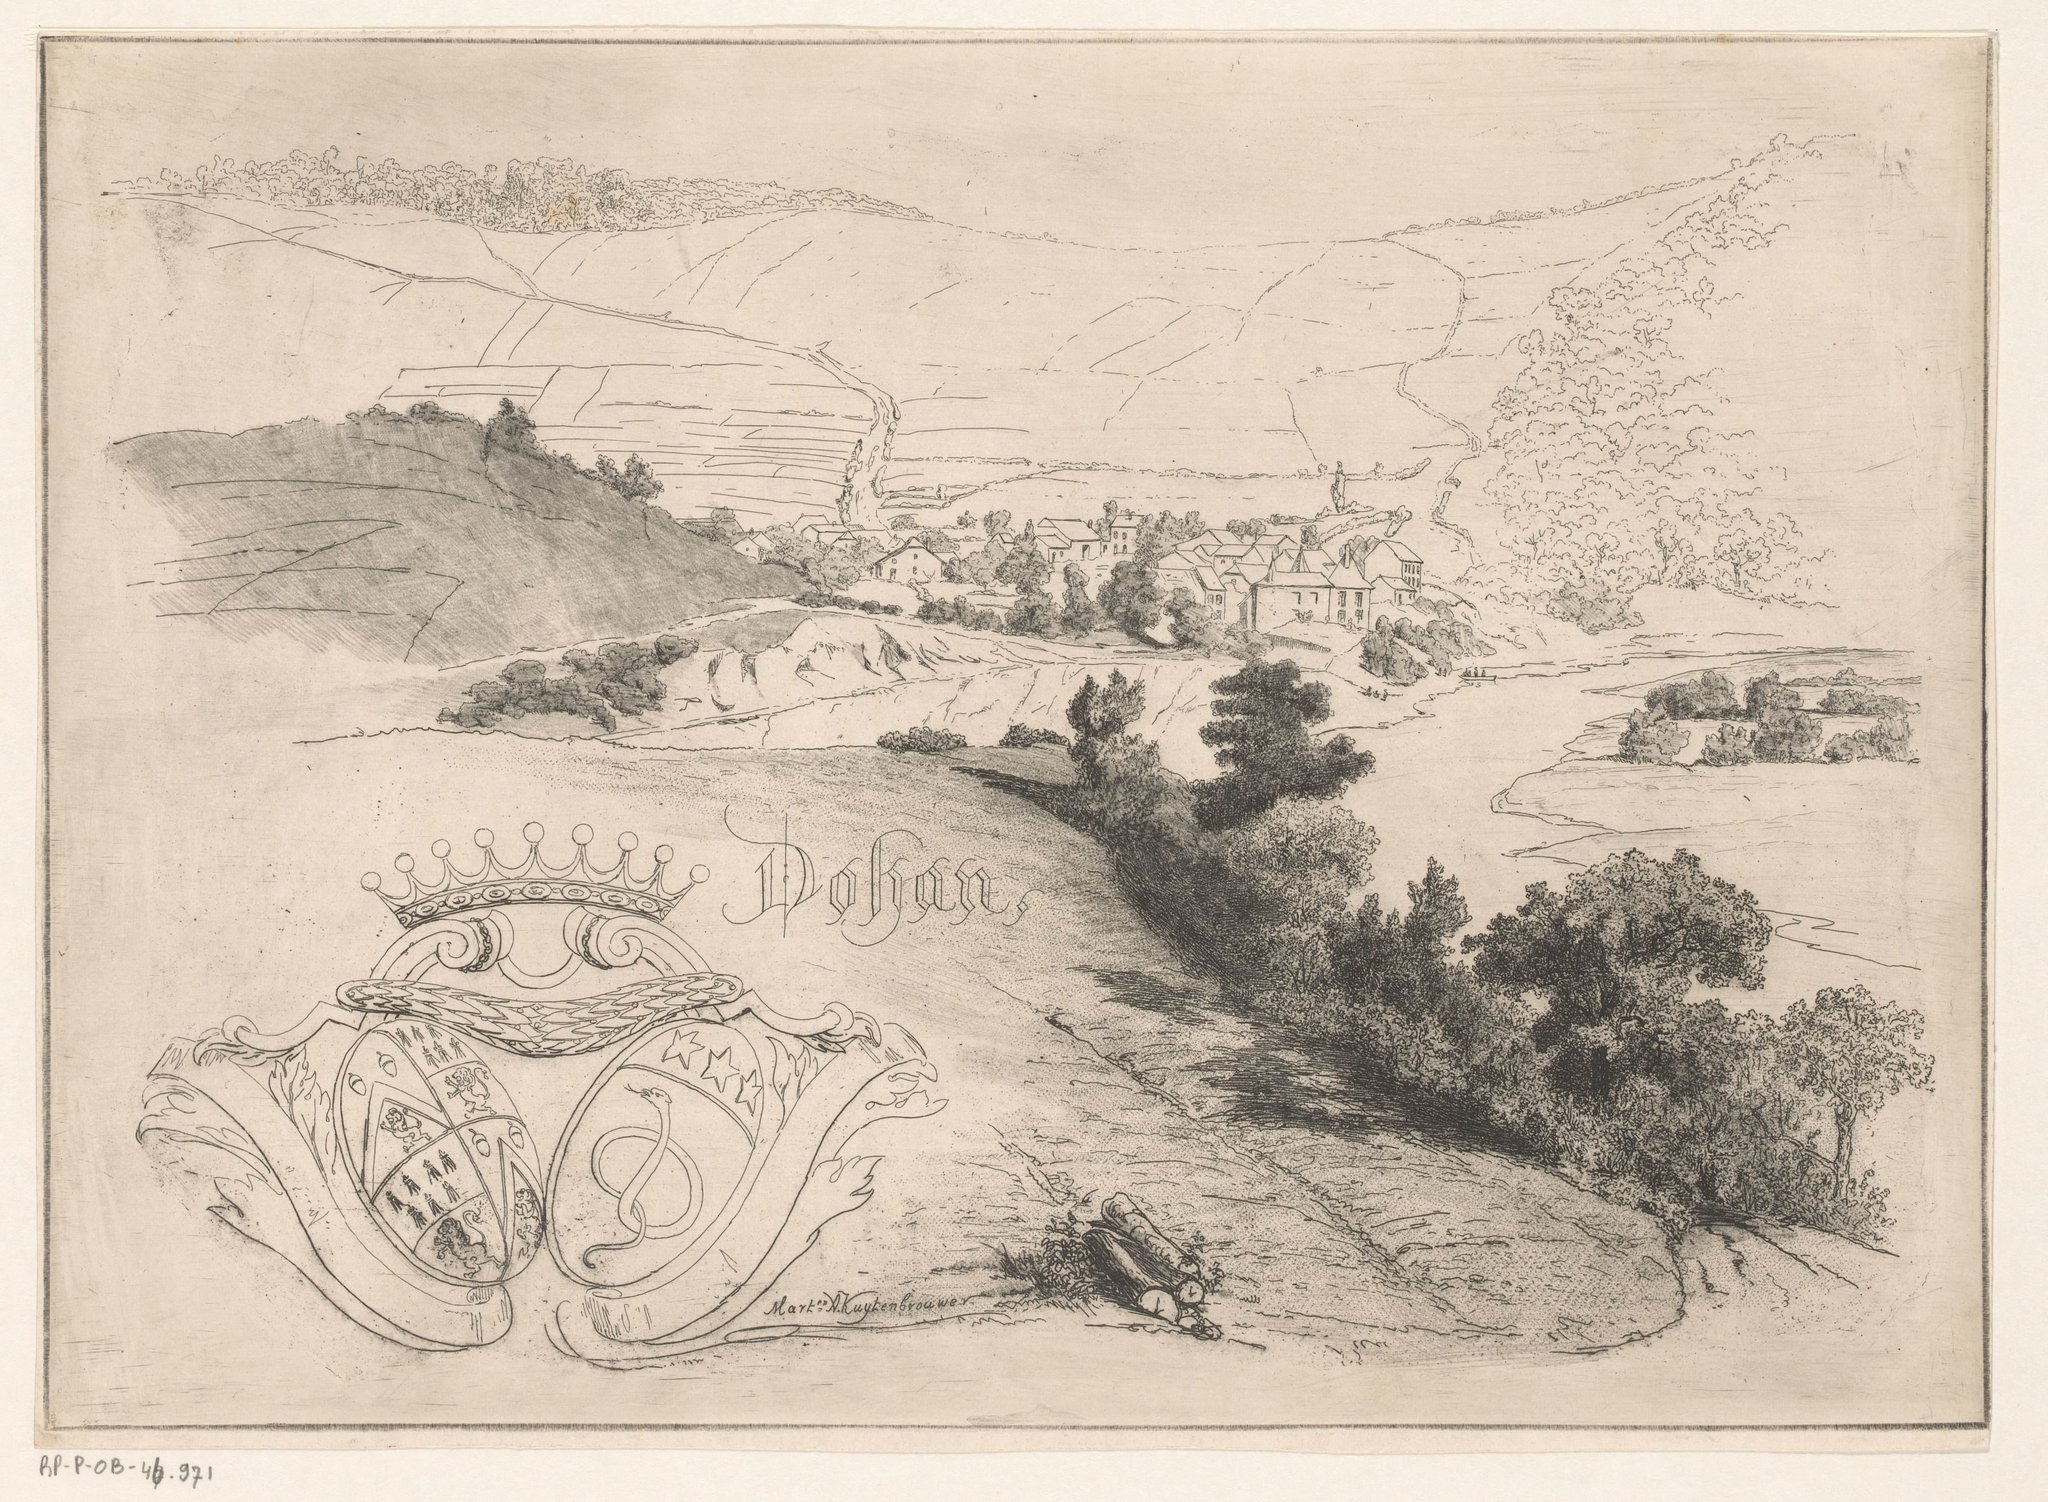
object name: print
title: Dohan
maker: martinus antonius kuytenbrouwer jr.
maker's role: draughtsman, painter, print maker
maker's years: 1821-1897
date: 1831-1897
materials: paper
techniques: drypoint, etching, intaglio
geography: netherlands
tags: low hill country, river, village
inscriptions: collector's mark: Lugt 2228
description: proefdruk van een illustratie voor: Alexis Victor Joly, Les Ardennes, Brussel: J. van Bruggenhoudt, 1854-1857.